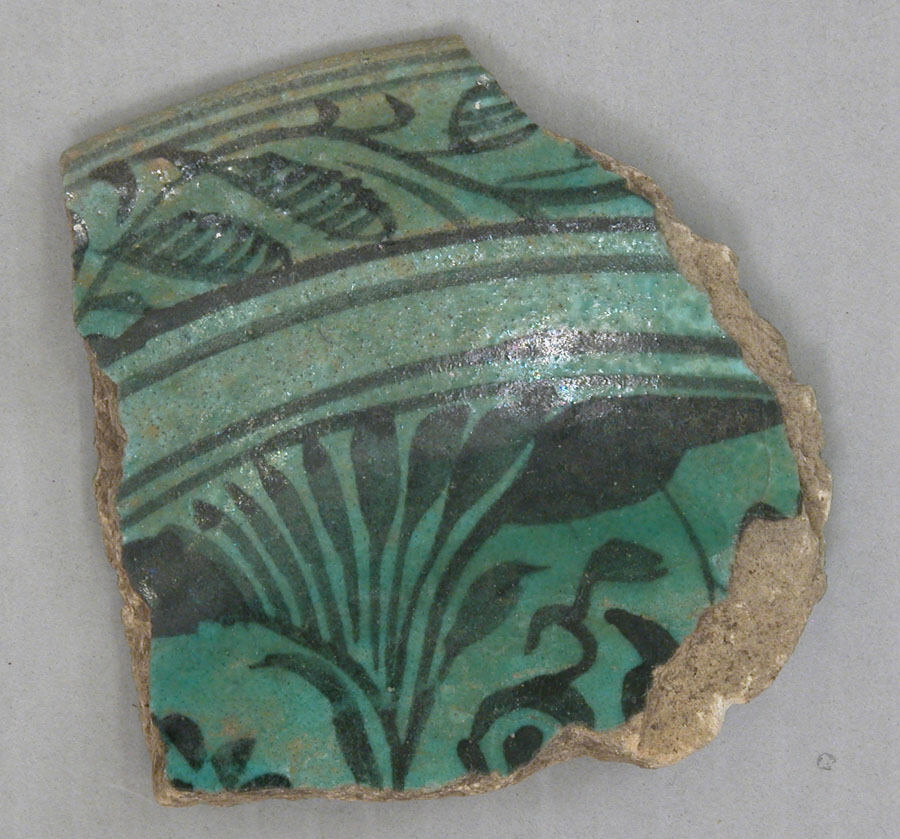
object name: fragment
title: Ceramic Fragment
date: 1301-1400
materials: stonepaste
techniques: painting, underglaze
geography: syria